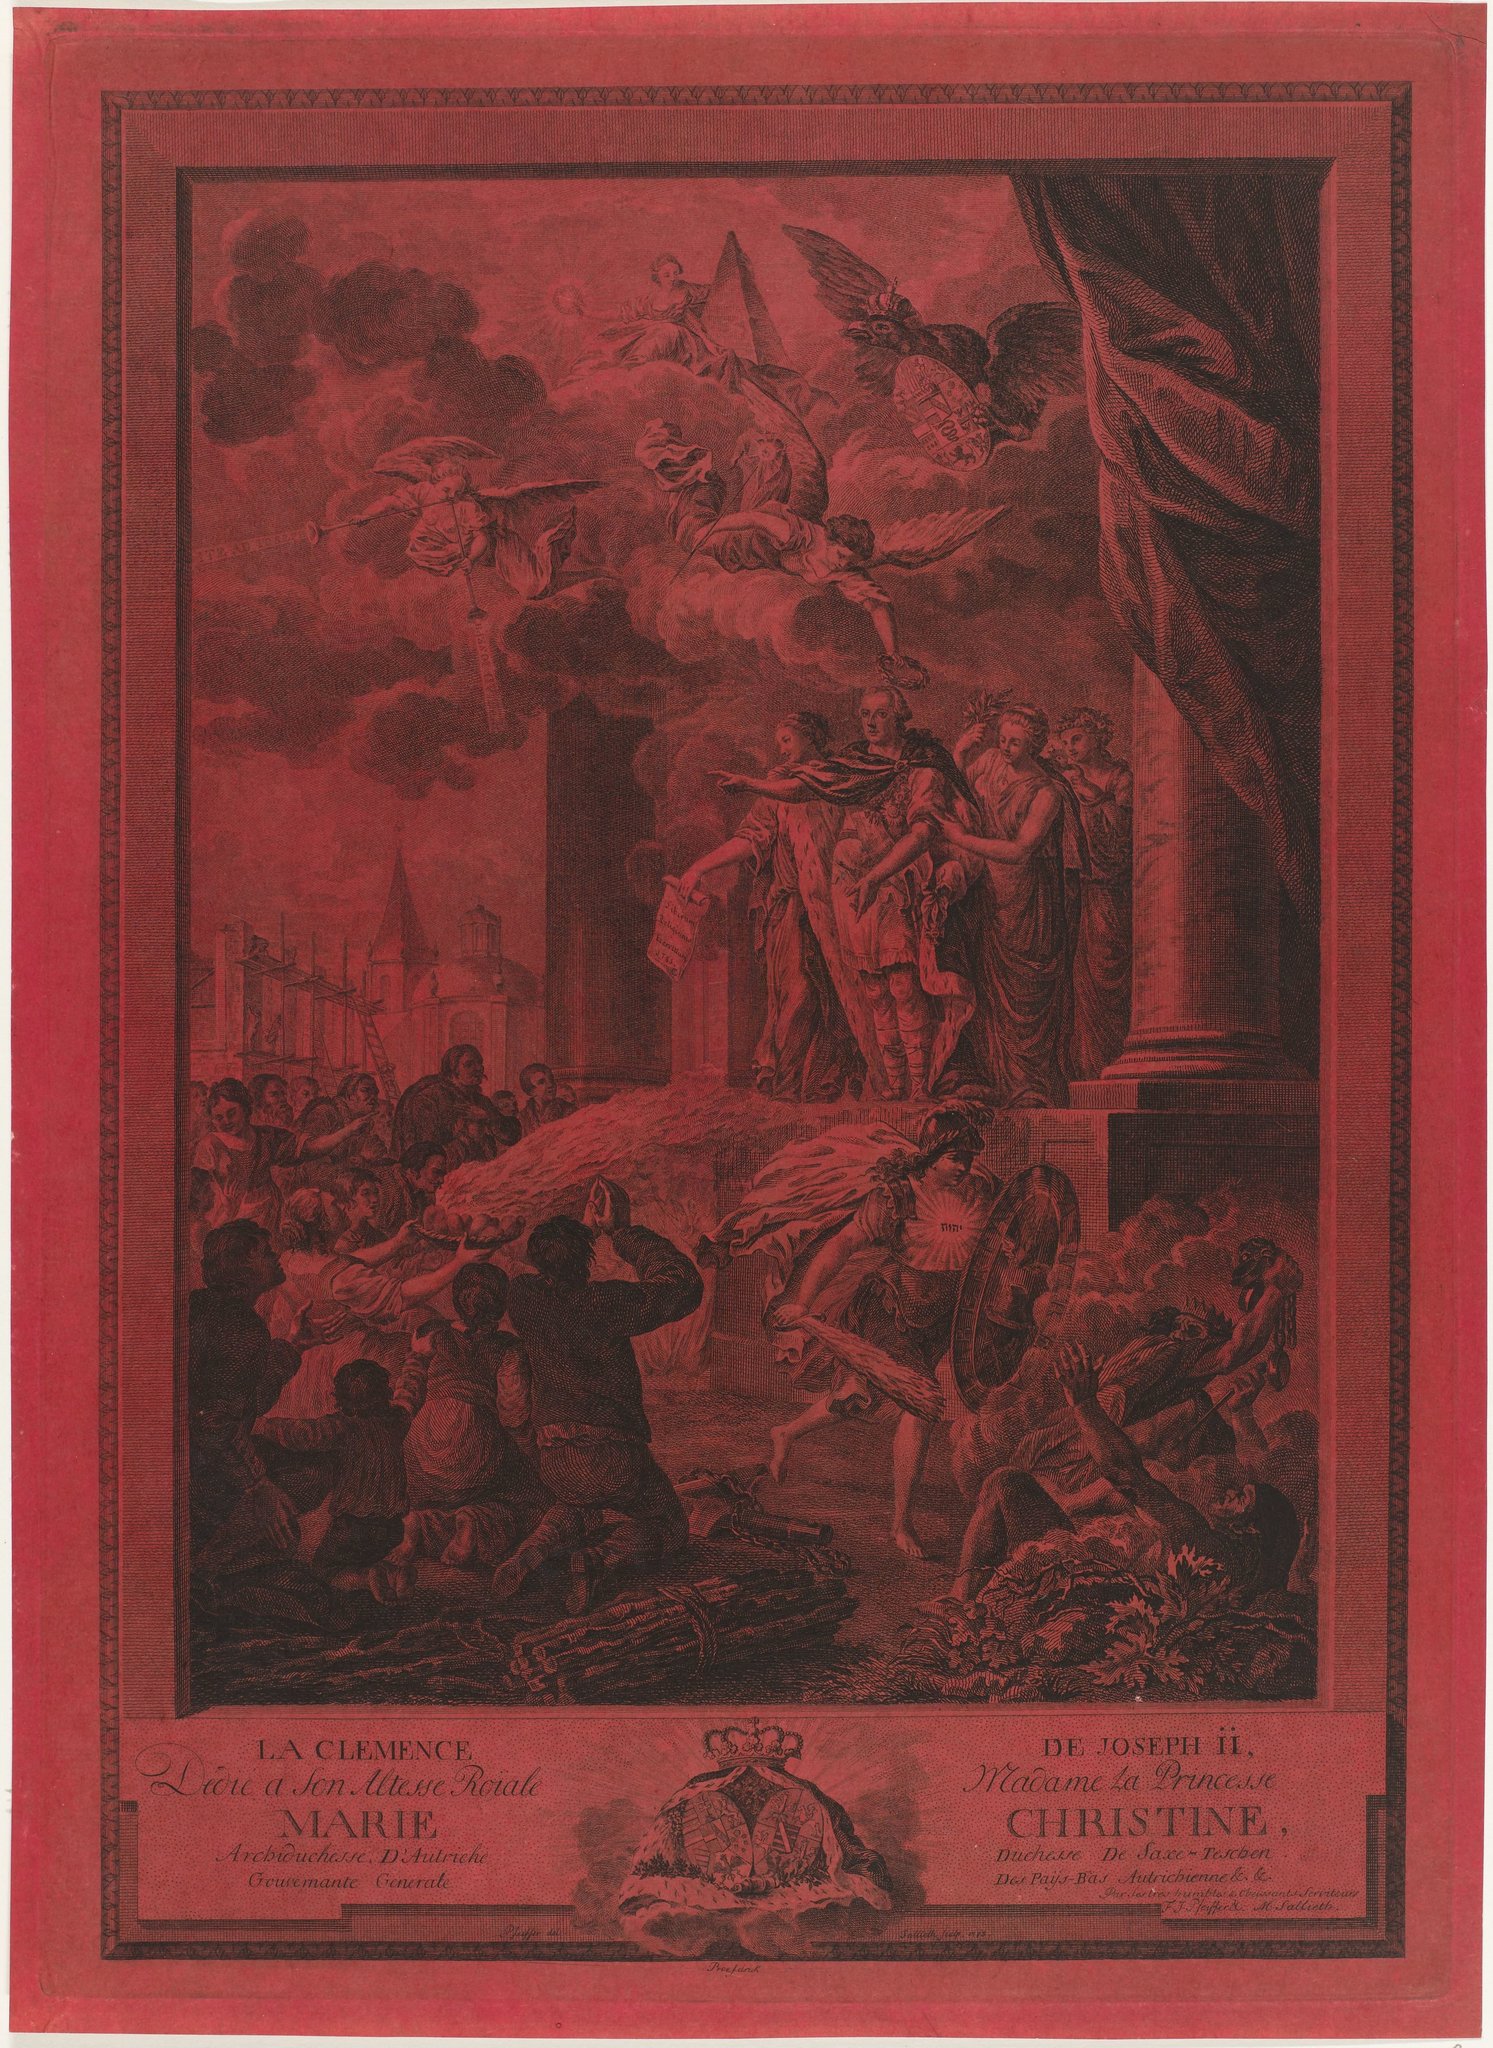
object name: print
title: Clementie van keizer Jozef II aan de protestanten, 1783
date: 1783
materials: paper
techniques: engraving, etching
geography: rotterdam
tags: vienna, maria christina van oostenrijk (1742-1798), jozef ii (duits keizer), prudence, 'prudentia'; 'prudenza' (ripa) ~ one of the four cardinal virtues, tolerance, long-suffering; 'longanimità', 'toleranza' (ripa) (+ abstract concept represented by female figure), indulgence, clemency; 'clemenza', 'clemenza & moderatione', 'indulgenza' (ripa) (+ abstract concept represented by female figure), the christian knight, 'miles christianus', building of church, allegories and personifications ~ protestantism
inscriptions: collector's mark: Lugt 2228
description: Allegorie op het edict van Joseph II over de godsdienstvrijheid voor protestanten, maart 1783. De keizer staat op het bordes van een tempel en wordt gekroond door de geest der Wijsheid. Naast de keizer de personificaties van Verdraagzaamheid, Goedertierenheid en Voorzichtigheid. Voor de keizer knielen (Hongaarse) protestantse onderdanen die hem in dankbaarheid hun harten aanbieden. Rechts worden de Dwingelandij en de Onwetendheid verjaagd door de Vrijheid van Godsdienst in harnas met vlammend zwaard en schild waarop 'Aurea libertas'. Op de achtergrond een protestantse kerk in aanbouw. Onderaan de titel, opdracht en wapens van de keizer en zijn zuster Maria Christina van Oostenrijk. Onderaan midden gemerkt: Proefdruk.